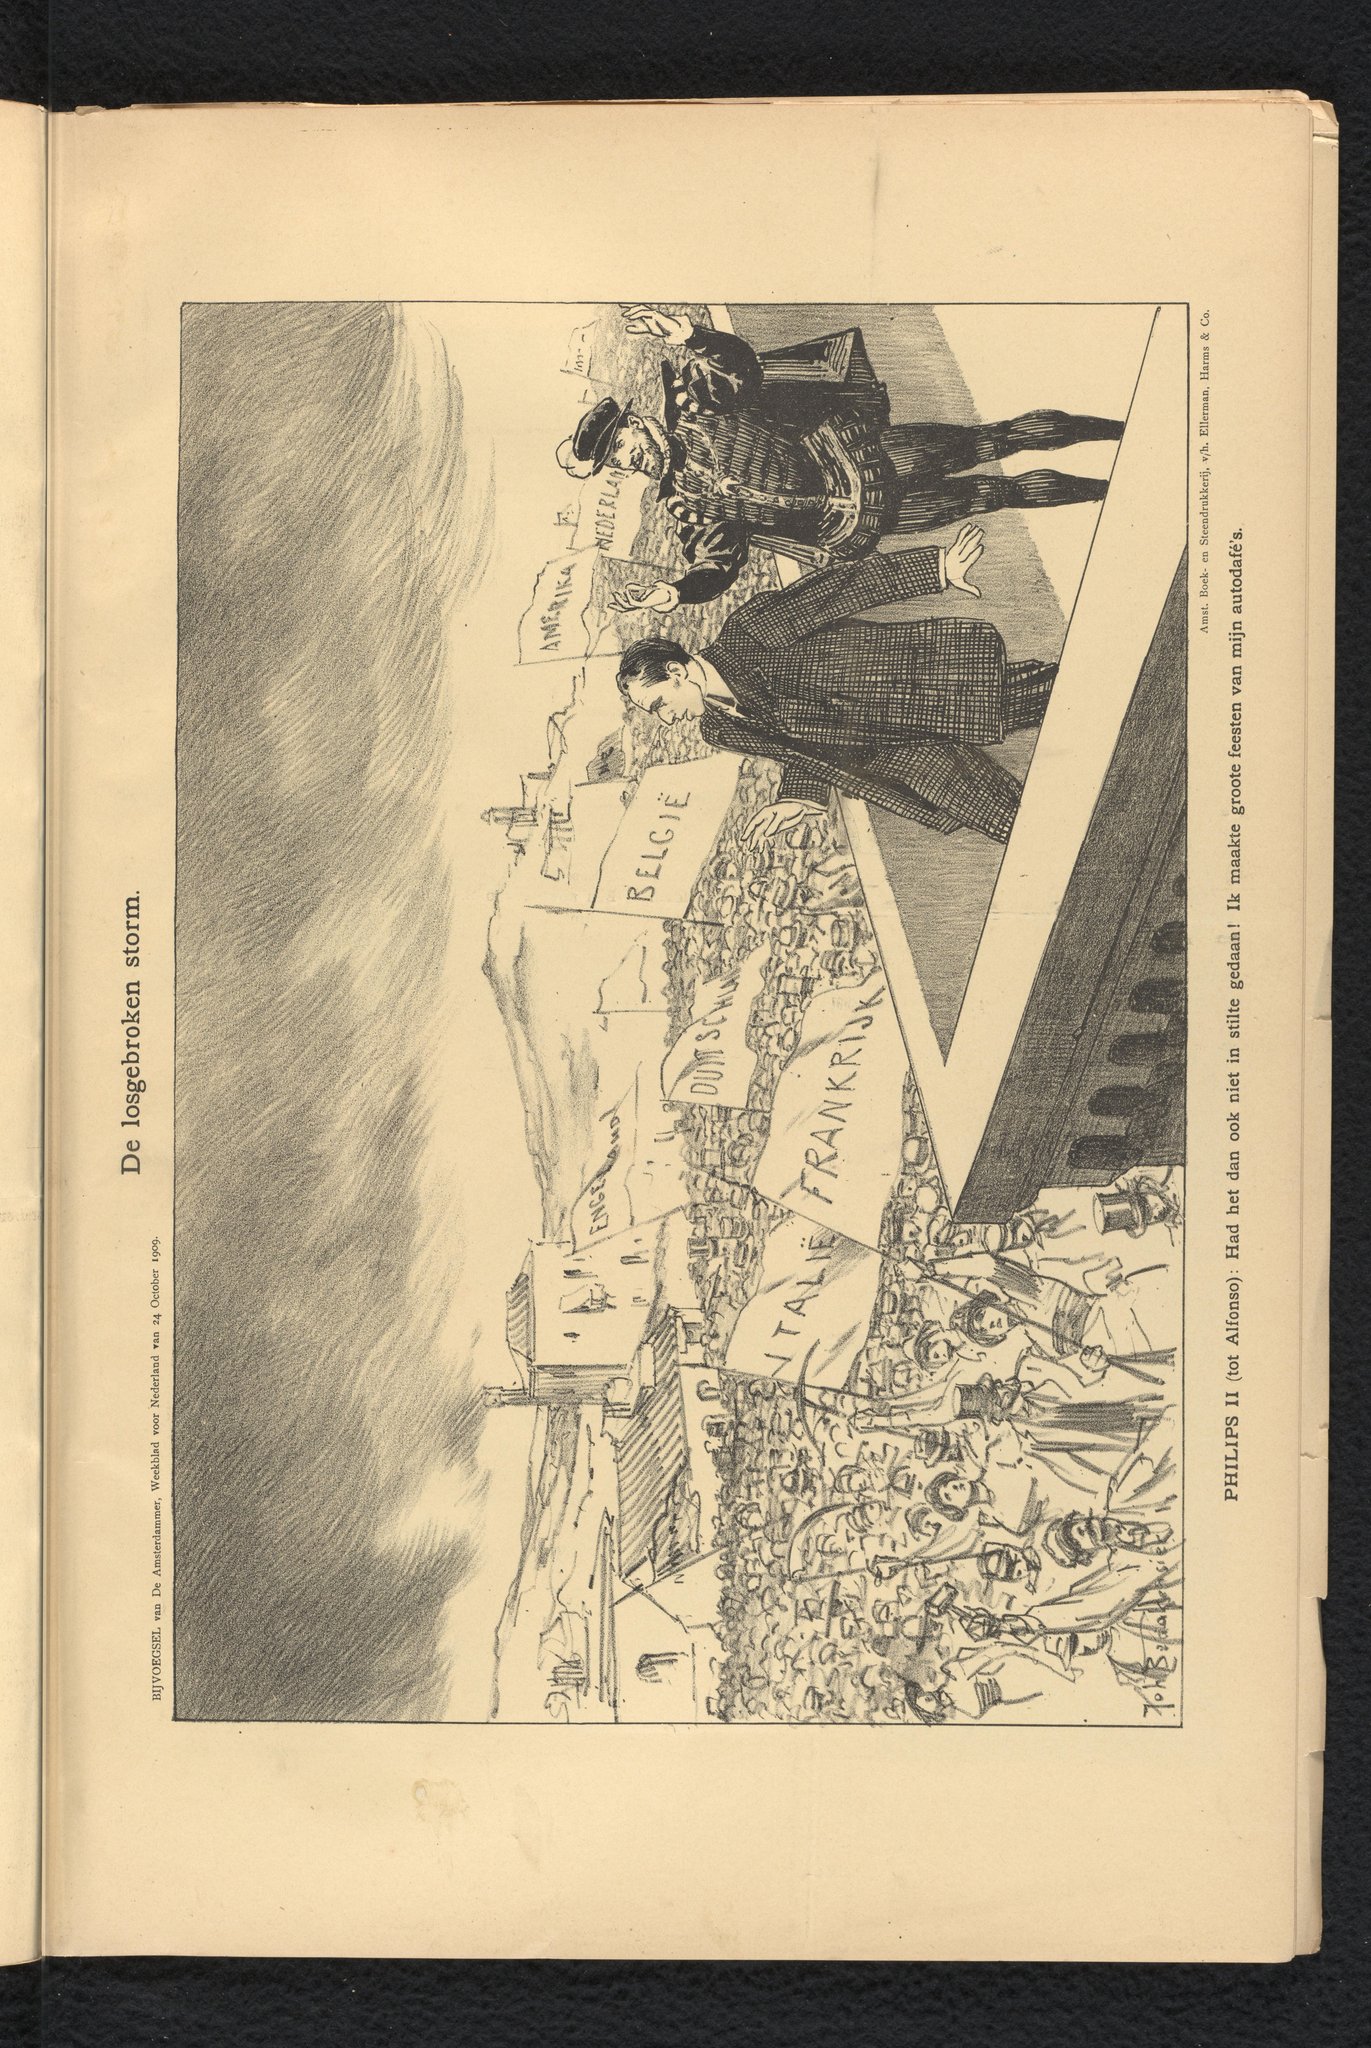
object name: cartoon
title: De losgebroken storm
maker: johan braakensiek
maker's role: draughtsman, print maker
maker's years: 1858-1940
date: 1909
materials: paper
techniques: lithograph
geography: netherlands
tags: philip ii of spain, political demonstration, political caricatures and satires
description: Filips II bij de Spaanse koning Alfons XIII op het balkon die schrikt van de grootschaligheid van de internationale protesten op straat tegen de executie van Ferrer.